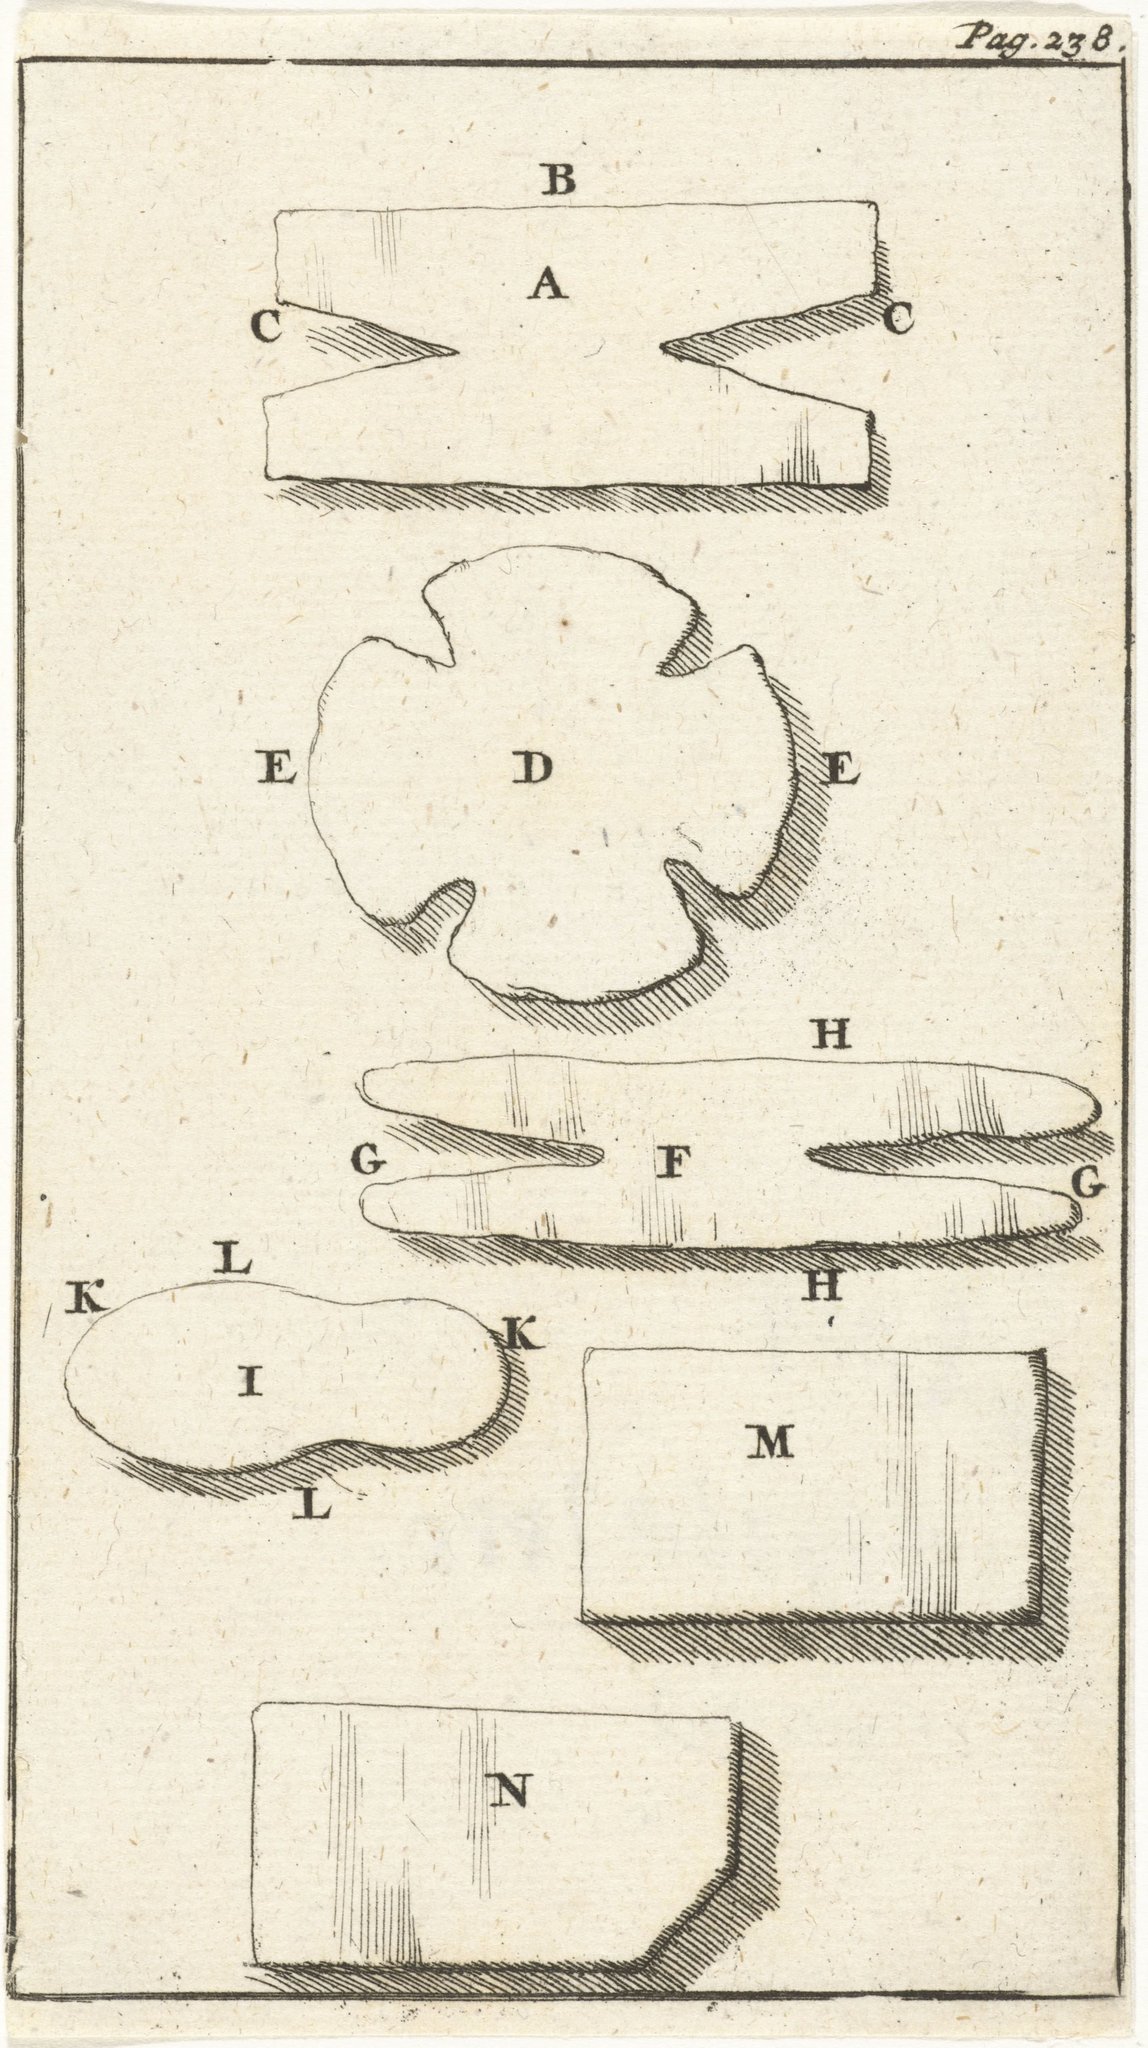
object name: book illustration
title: Weergave van verschillende verbanden A-N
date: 1691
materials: paper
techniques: etching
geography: amsterdam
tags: dressing, bandage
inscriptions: collector's mark: Lugt 2228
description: Illustratie uit: Verduc, Laurent. Het Parische verband-huis, waarin getoont werd, de wyse om alle fracturen en luxatien (...) te genesen. Amsterdam: Jan Claesz ten Hoorn, 1691.